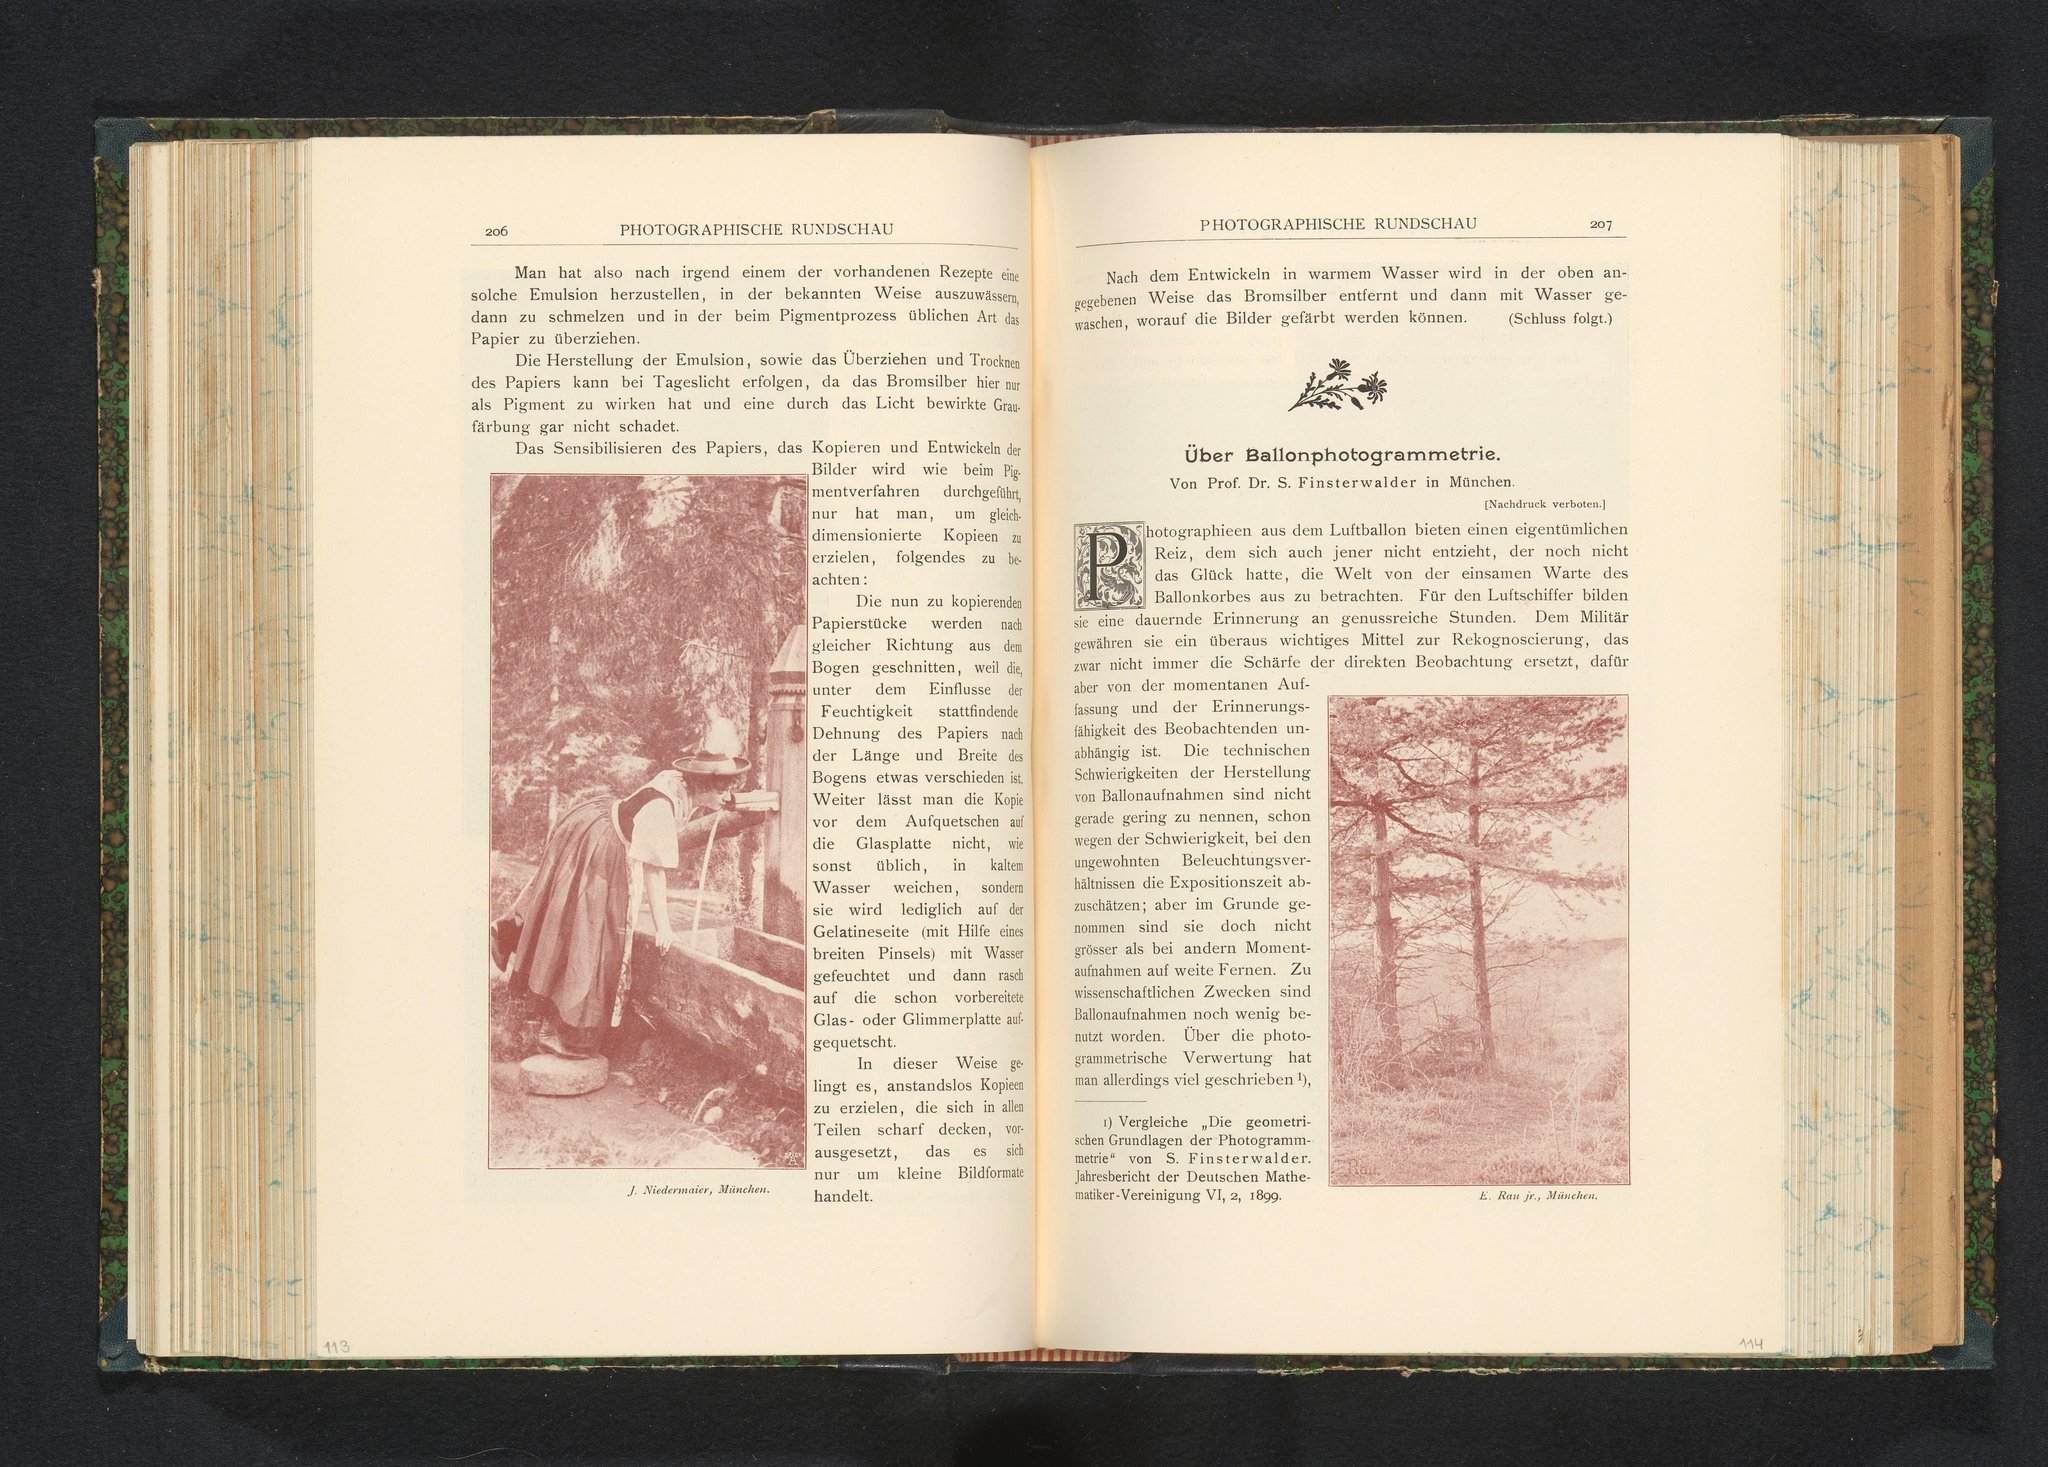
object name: page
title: Tweetal bomen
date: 1894-1899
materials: paper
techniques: autotype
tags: trees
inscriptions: monogram: ‘Dr A Co’